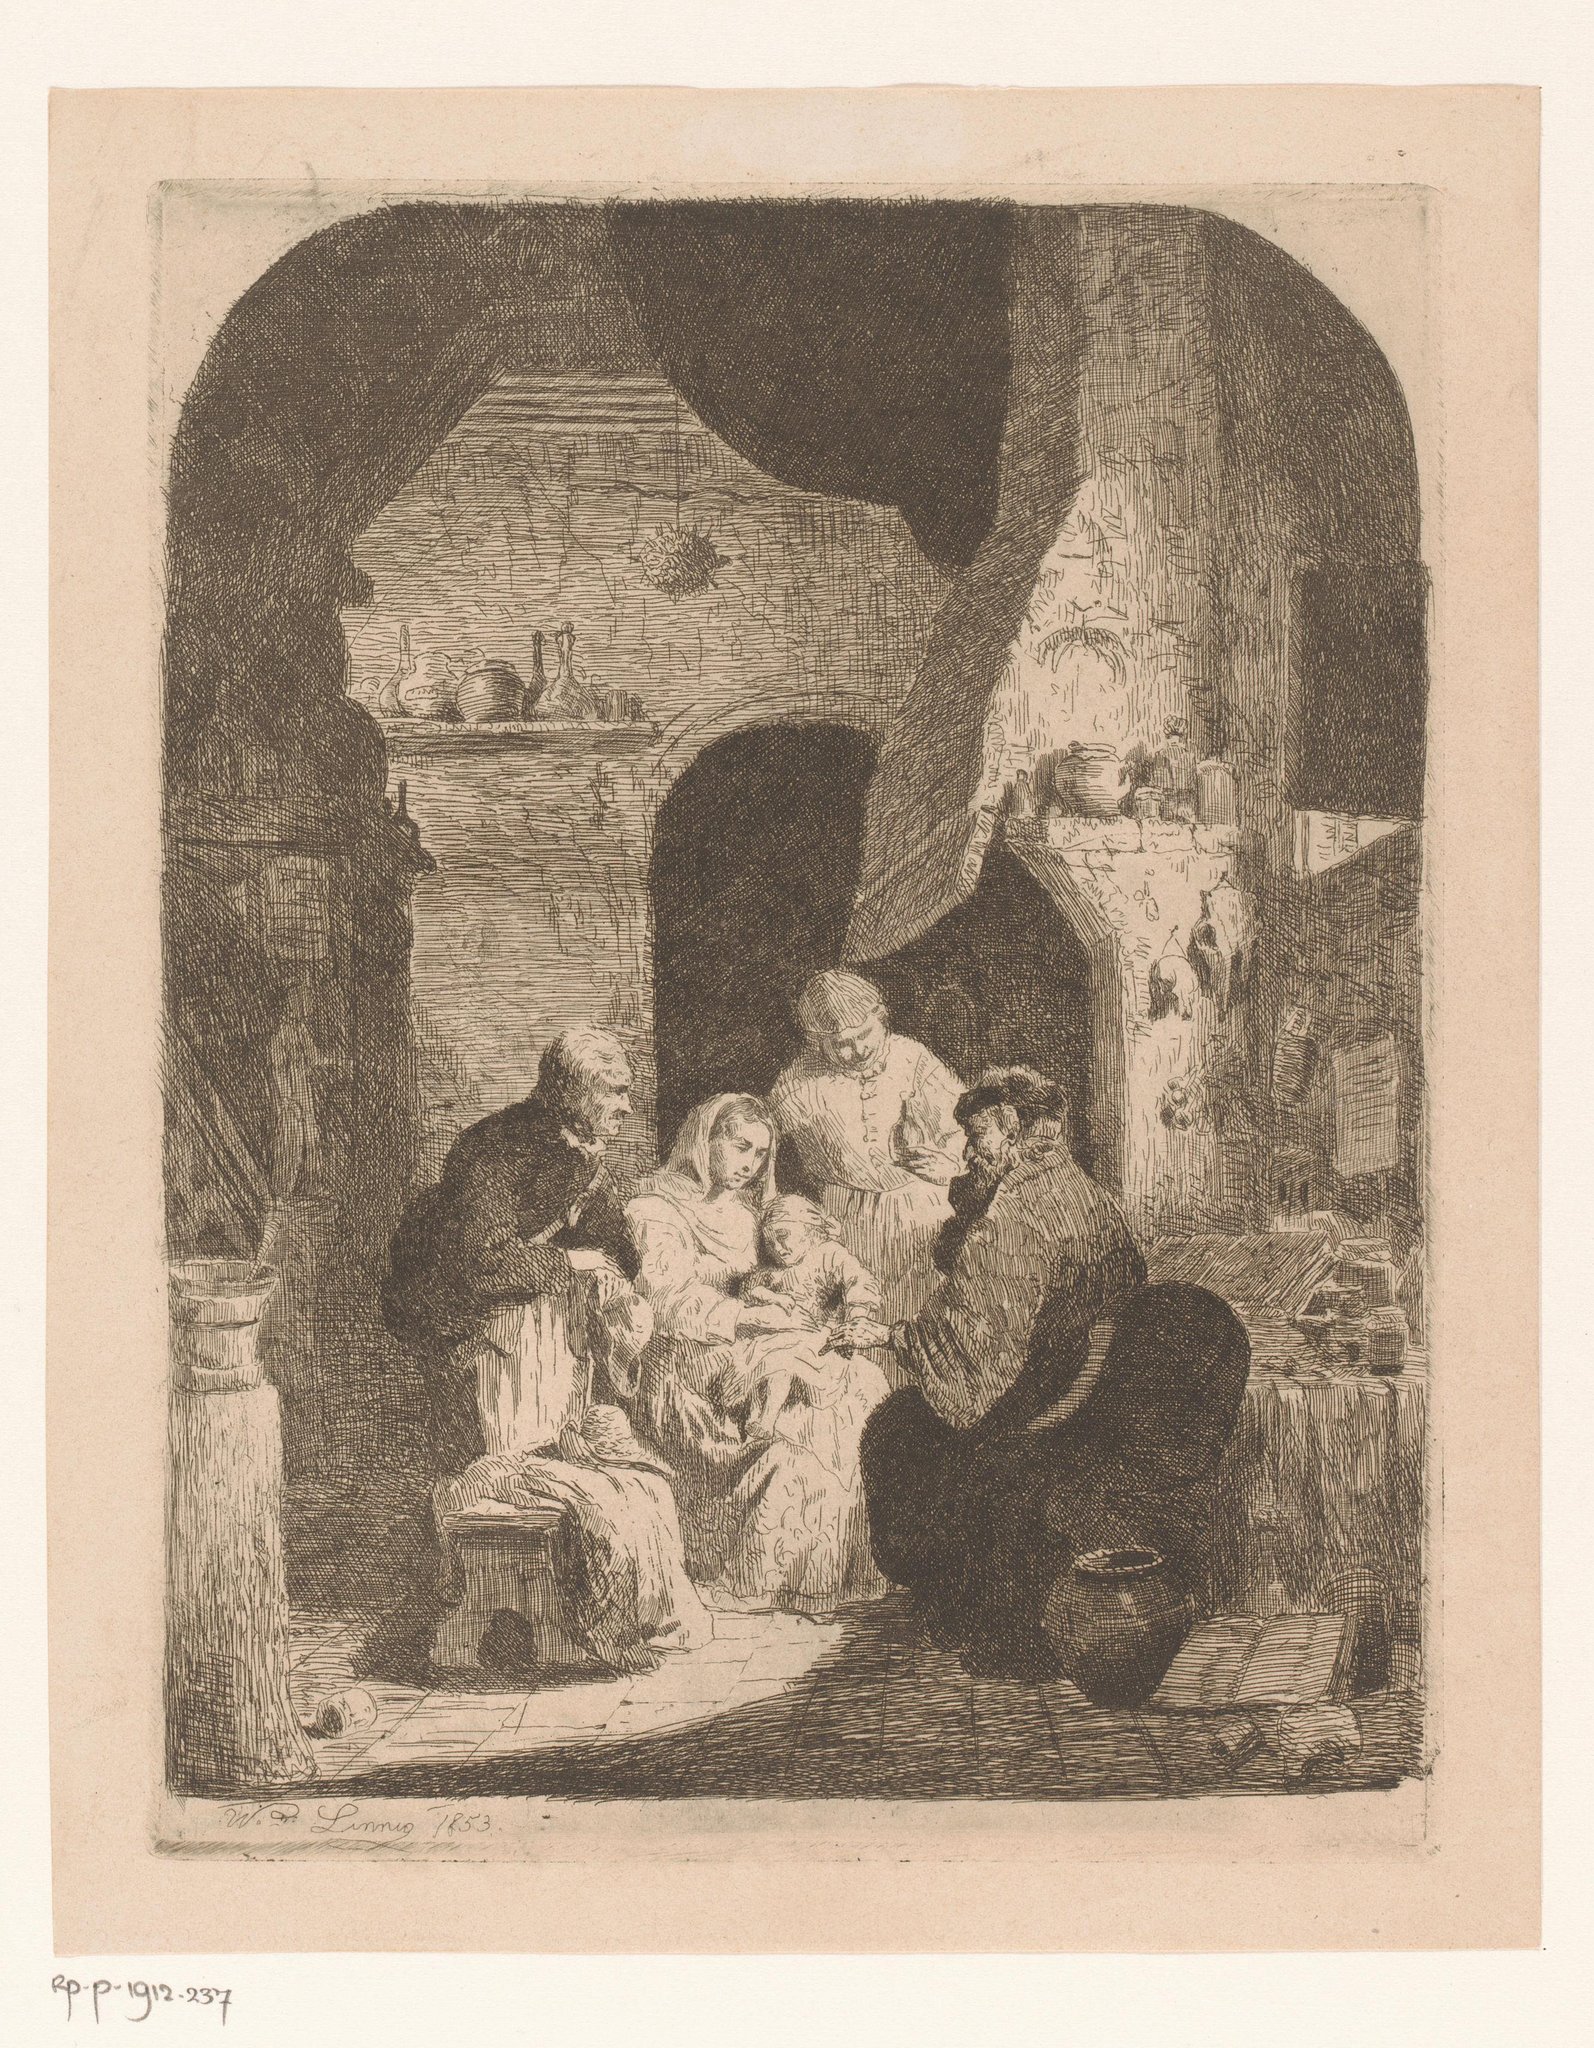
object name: print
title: Gezin met een ziek kind bij de dokter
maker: willem linnig (i)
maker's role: print maker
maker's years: 1819-1885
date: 1853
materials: paper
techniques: etching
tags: physician, doctor, hourglass, (human) skeleton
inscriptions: collector's mark: Lugt 1485, annotation: ‘la planche est detruite par ce que l'eau forte avait mordu trop âpre / il existe 3 exemplaires de cet état’, collector's mark: Lugt 2228